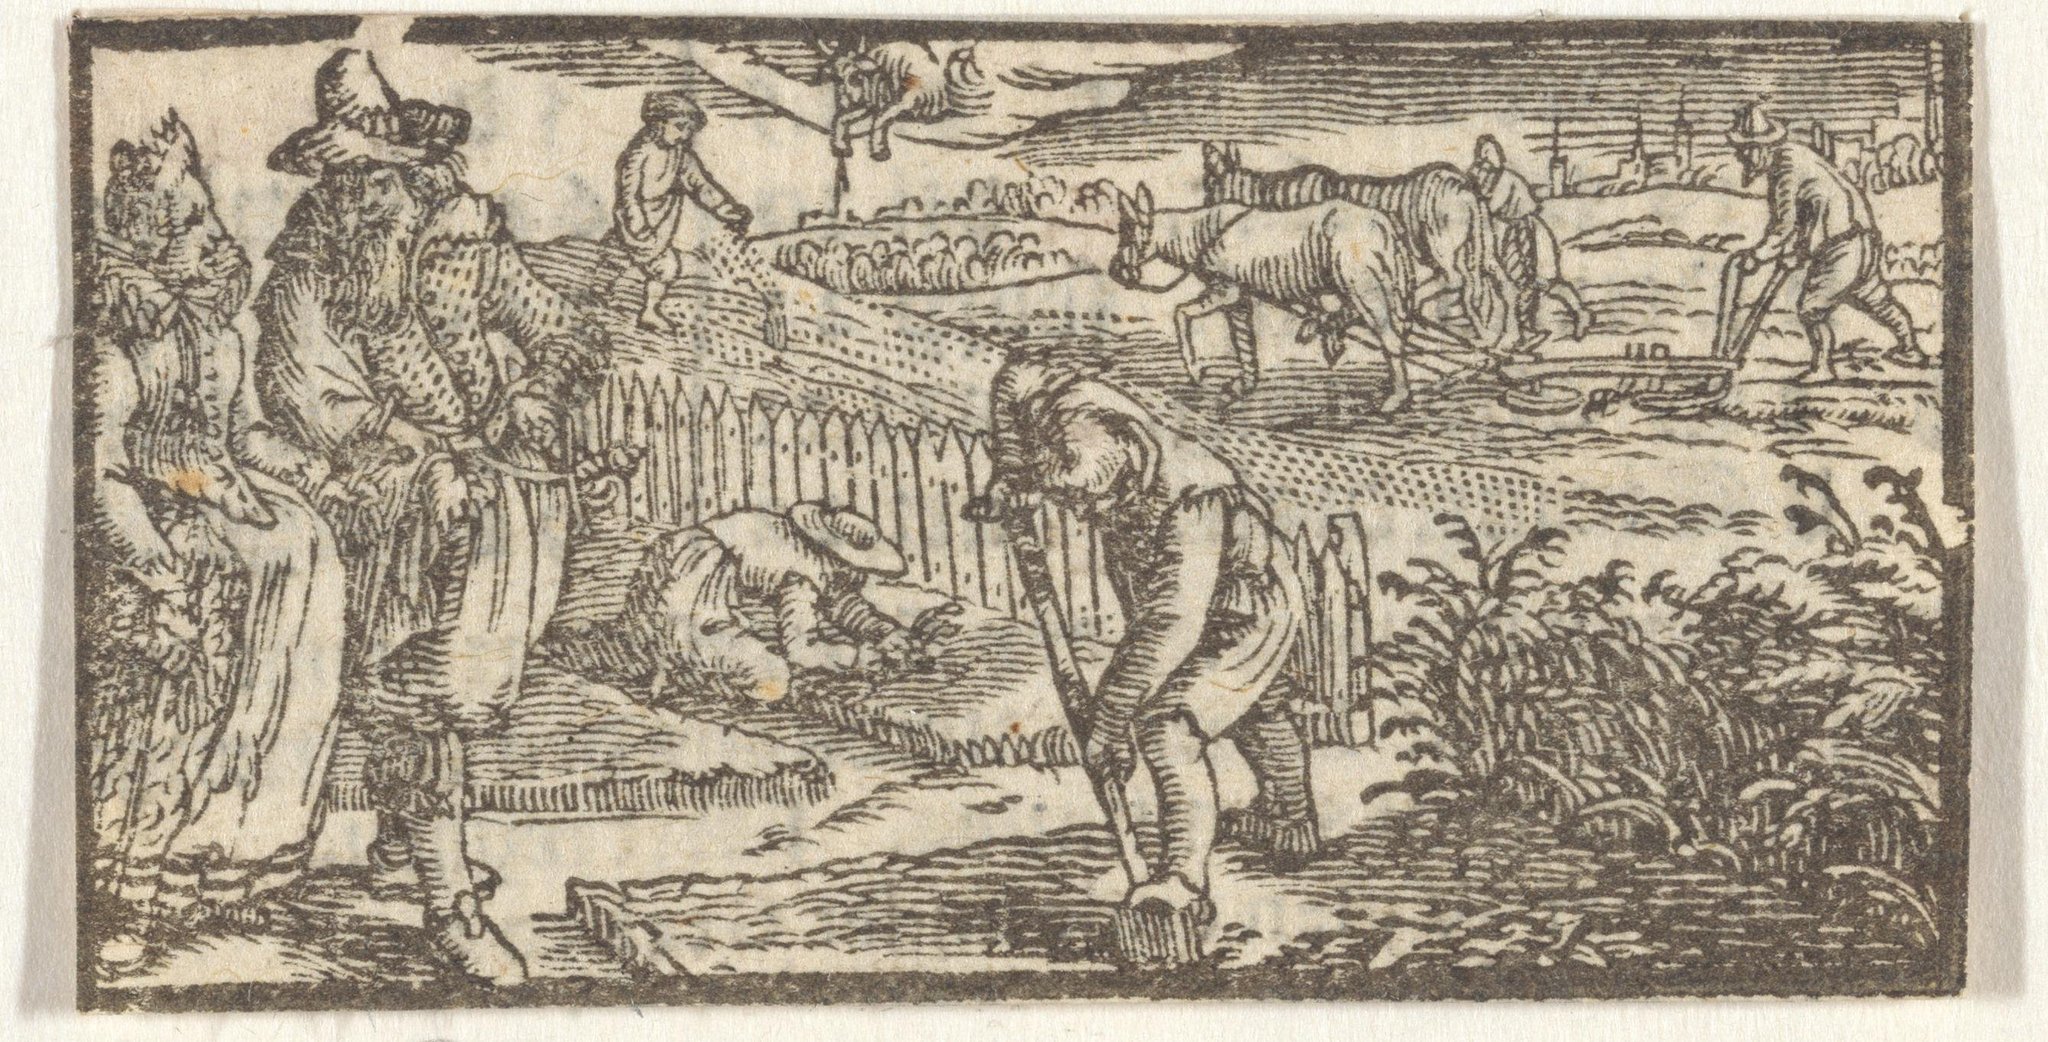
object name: print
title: April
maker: Anonymous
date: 1600-1699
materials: paper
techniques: letterpress printing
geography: netherlands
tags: april and its 'labours' (+ with taurus (april)), garden, sowing, ploughing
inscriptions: collector's mark: Lugt 2228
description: Figuren werkend in een omheinde tuin en op het land. Midden boven een stier.